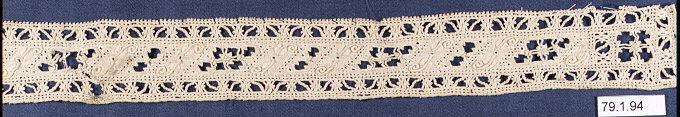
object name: strip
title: Strip with corner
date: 1501-1600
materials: linen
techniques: embroidery